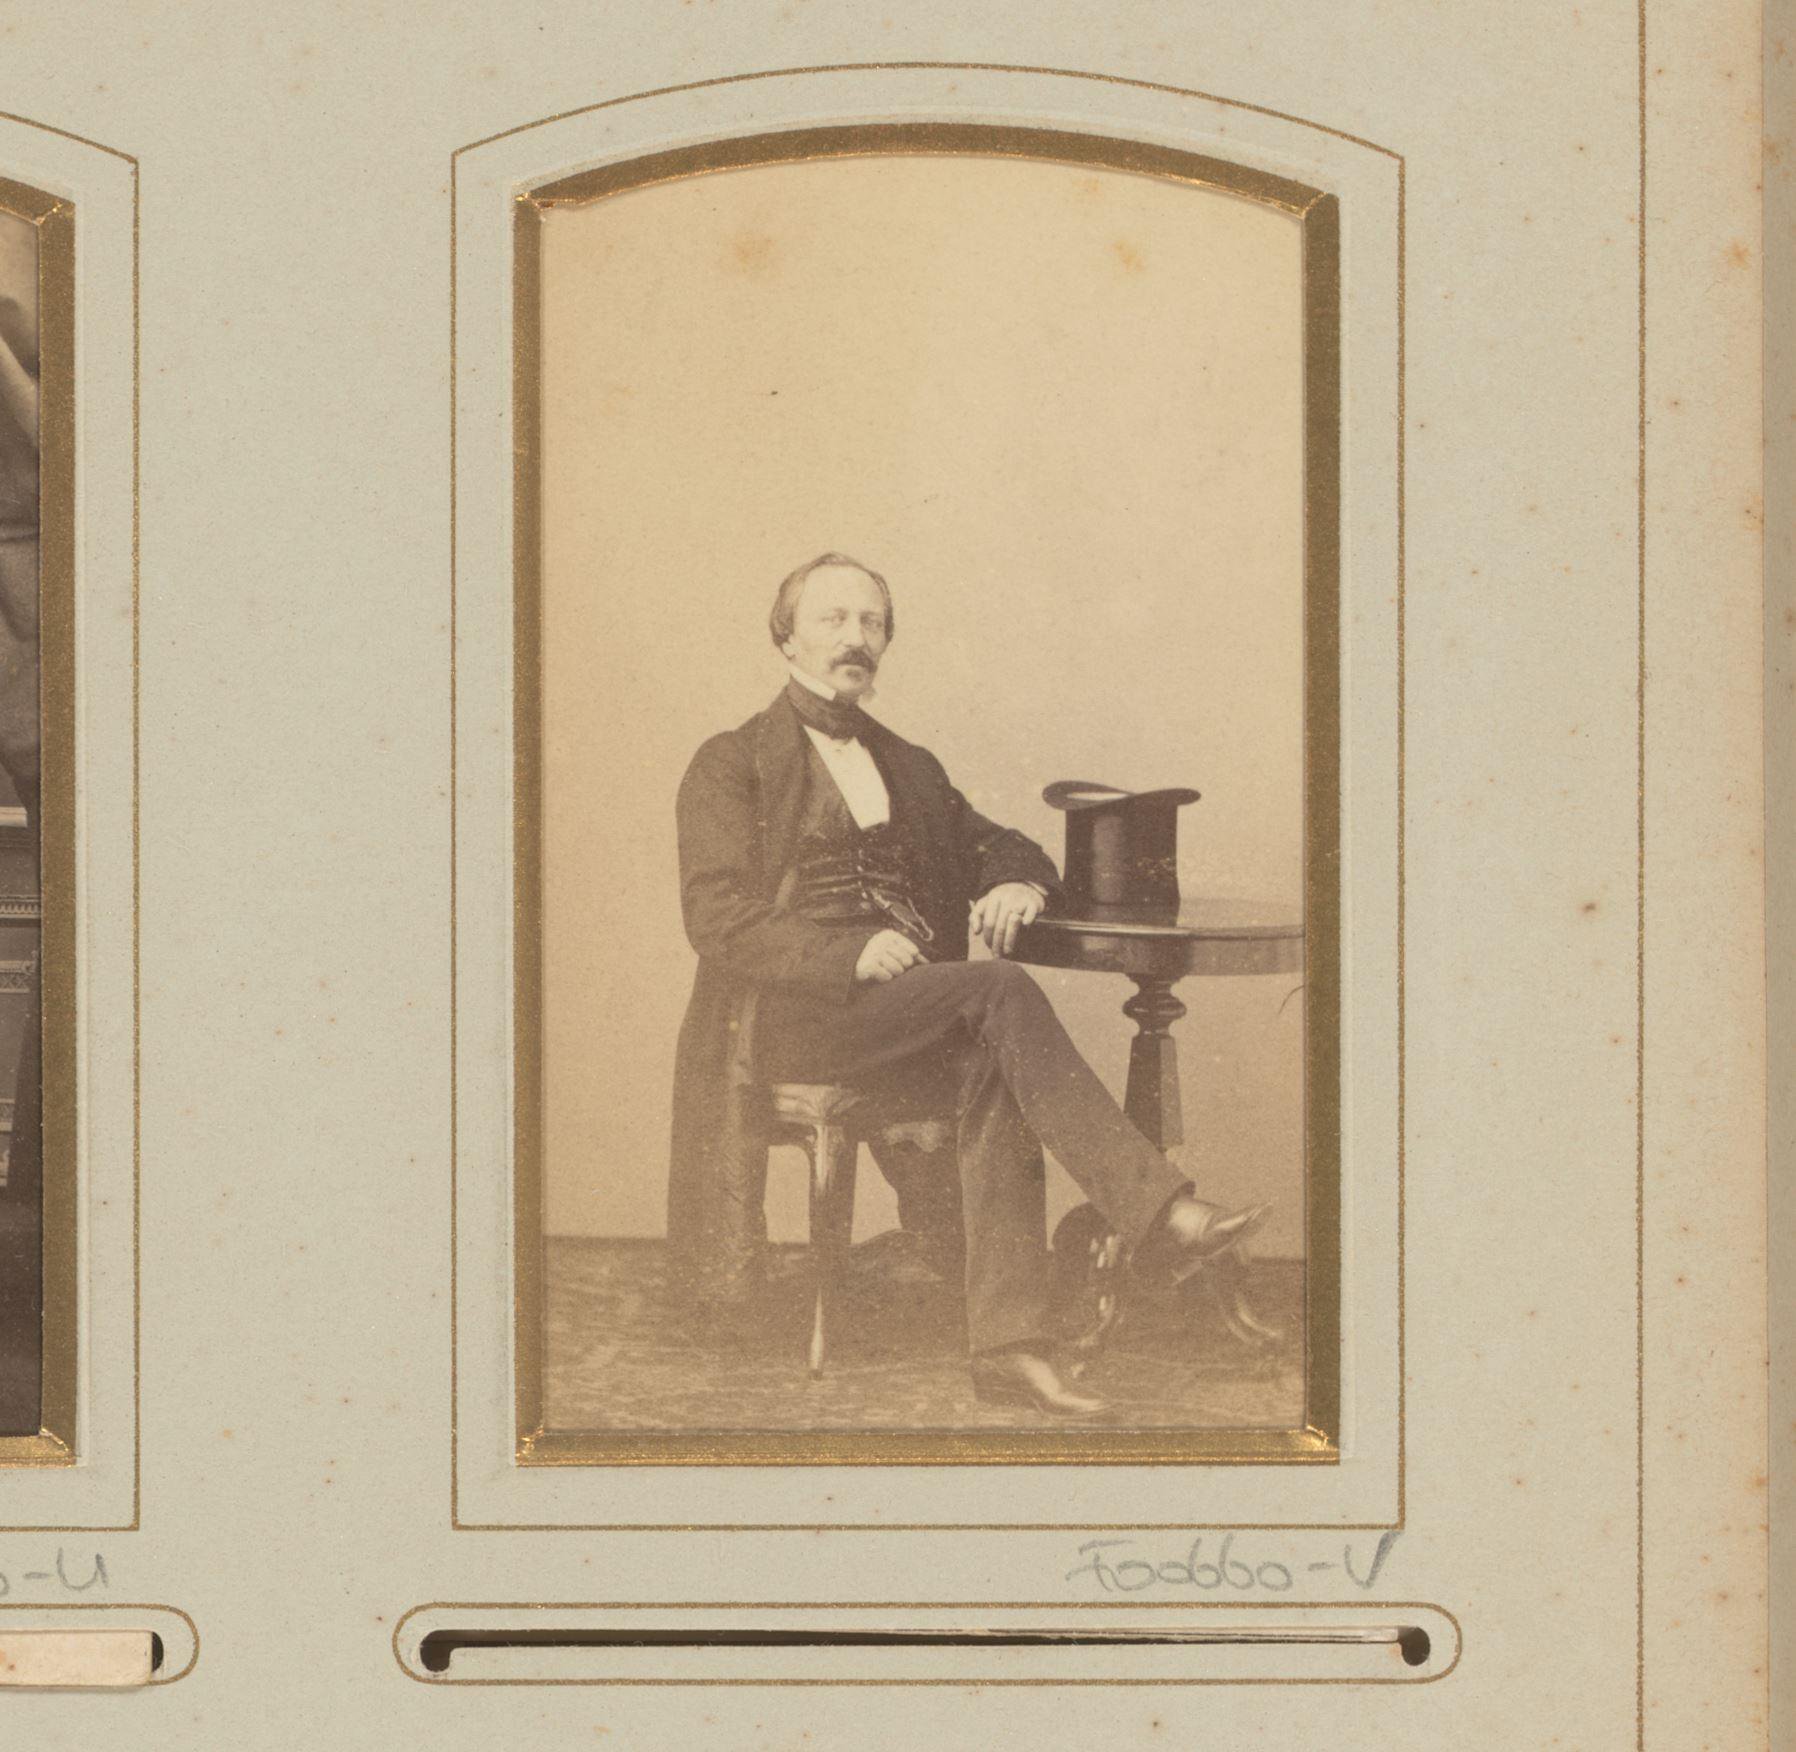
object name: photograph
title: Portret van een man aan een tafel waarop een hoed ligt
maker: jules géruzet (fotograaf)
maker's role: fotograaf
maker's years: 1817-1874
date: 1865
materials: cardboard, photographic support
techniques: albumen print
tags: historical persons, table, head-gear: top hat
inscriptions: inscription: ‘JULES GÉRUZET,/ PHOTOGRAPHE,/ 27bis Rue de l'Ecuyer,/ BRUXELLES.’